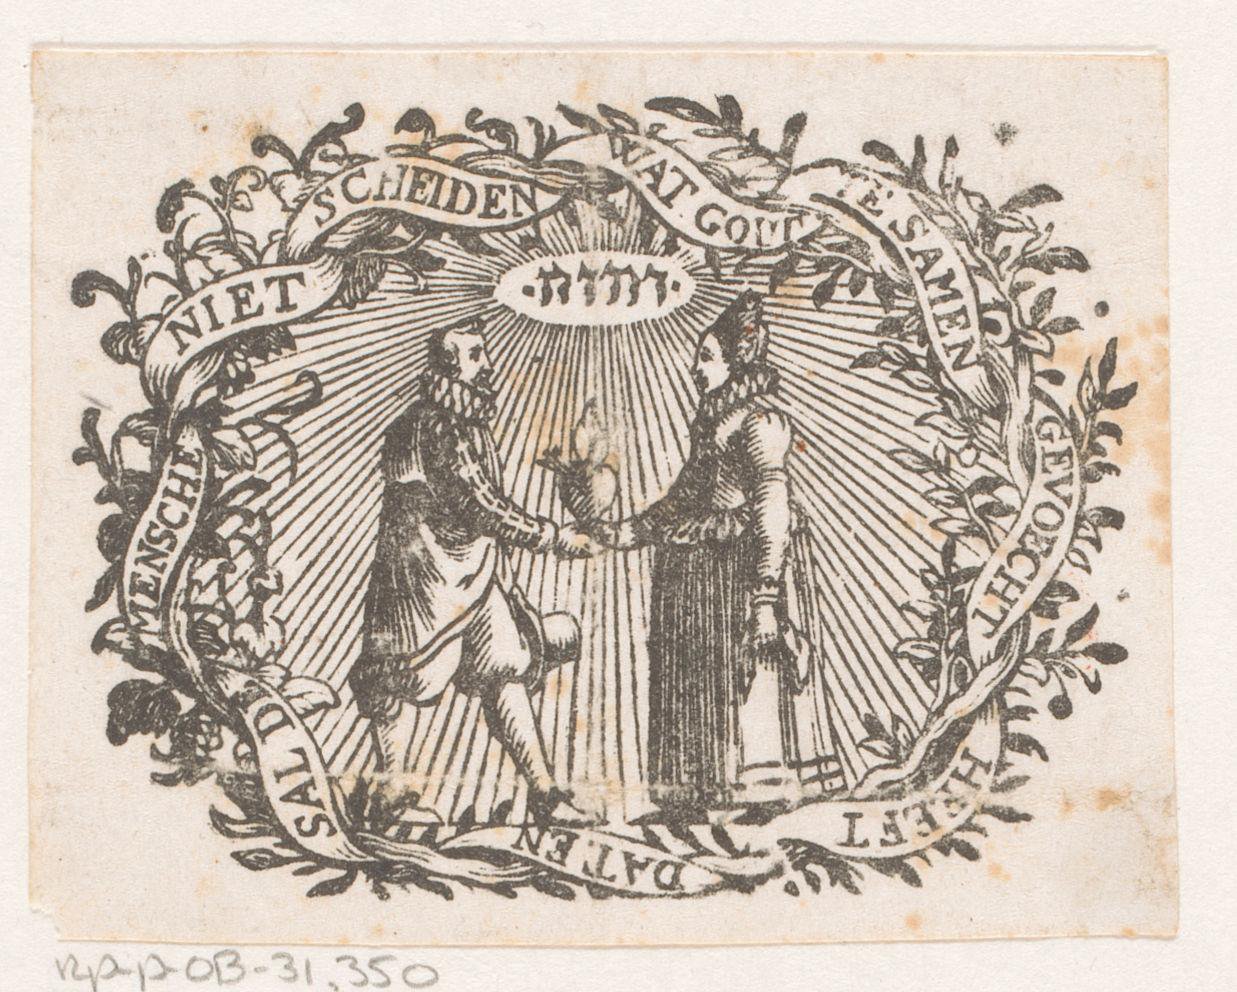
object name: print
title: Allegorie op het huwelijk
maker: Anonymous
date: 1600-1699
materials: paper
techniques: woodcut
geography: netherlands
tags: marriage in church ~ the sixth of the seven sacraments, heart symbolism, couple of lovers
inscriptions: collector's mark: Lugt 240, collector's mark: Lugt 698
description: Een vrouw en een man houden elkaars rechterhand vast. In het midden een brandend hart met een pijl. In de cartouche een regel uit Mattheüs 19:6b, verwijzend naar het huwelijk tussen man en vrouw.